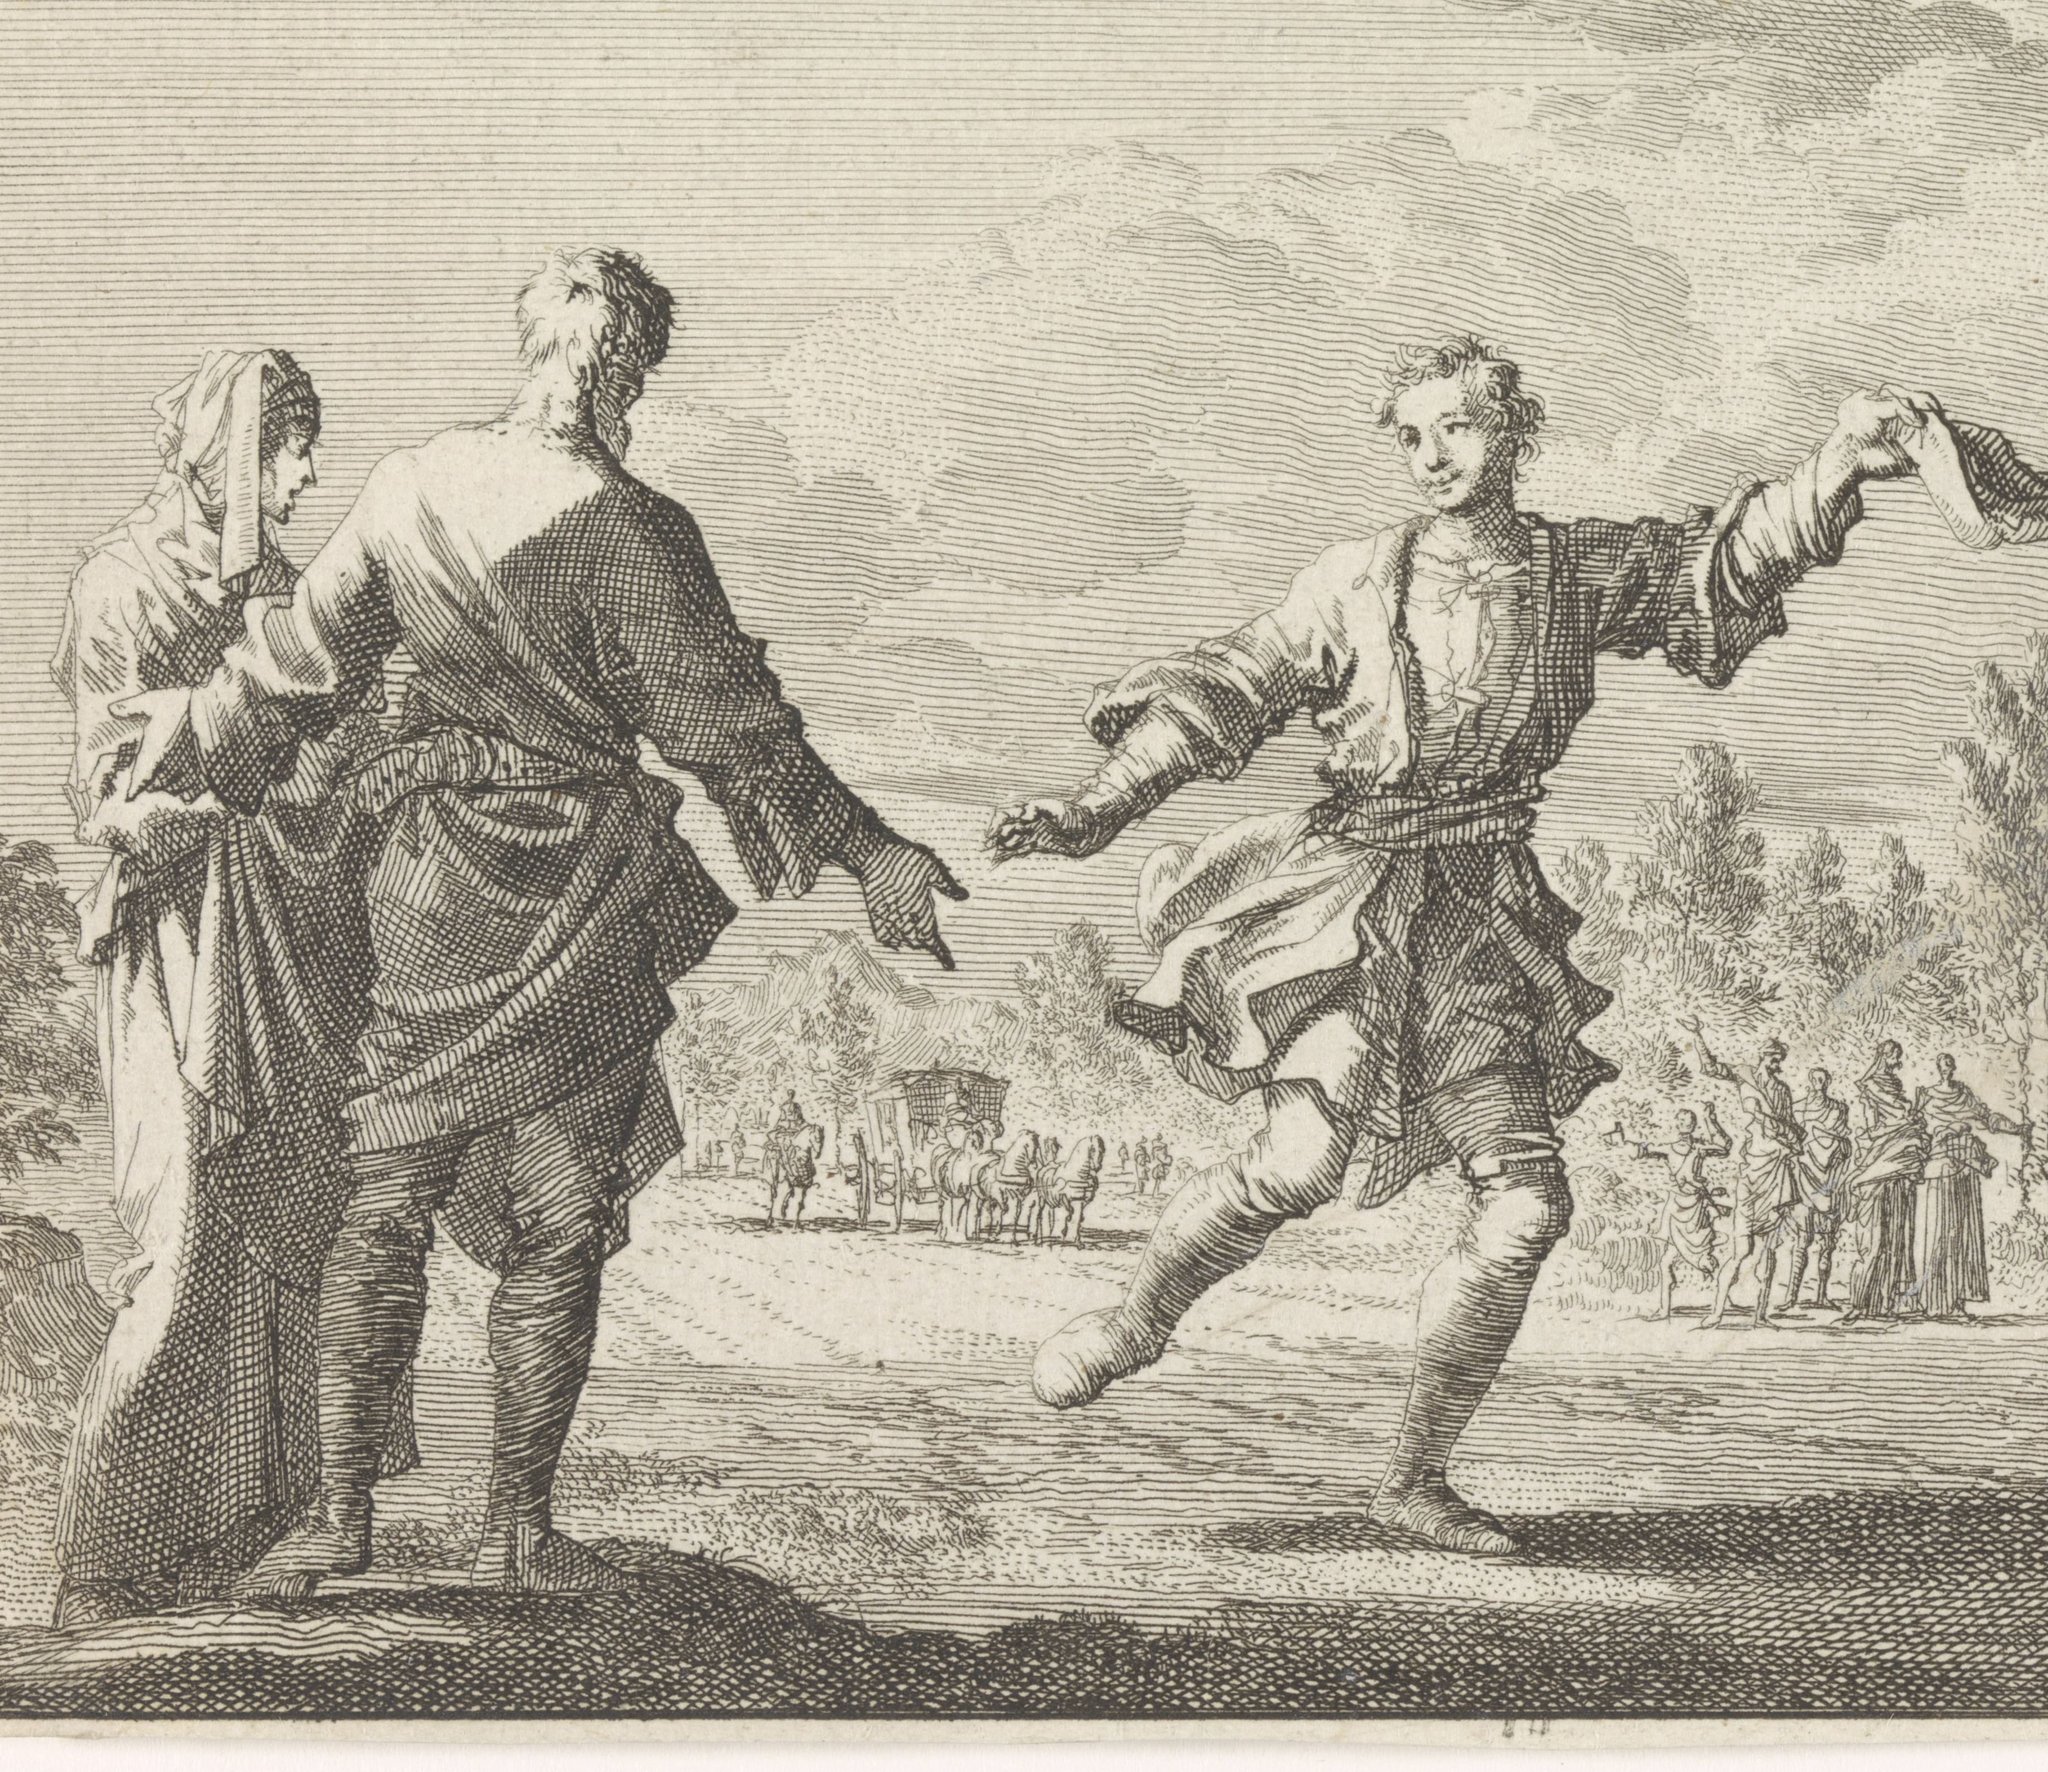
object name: print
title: Jongeling, wuivend met een hoed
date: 1695-1705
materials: paper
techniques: etching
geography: nuremberg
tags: baring the head, lifting one's hat, youth, adolescent, street, abstract ideas and concepts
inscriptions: collector's mark: Lugt 240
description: Boekillustratie voor Weigel, Christoph. Ethica Naturalis seu Documenta Moralia e Variis rerum Naturalium proprietatibus Virtutum Vitiorumq symbolicis imaginibus collecta. Neurenberg: Christoph Weigel: c. 1700.